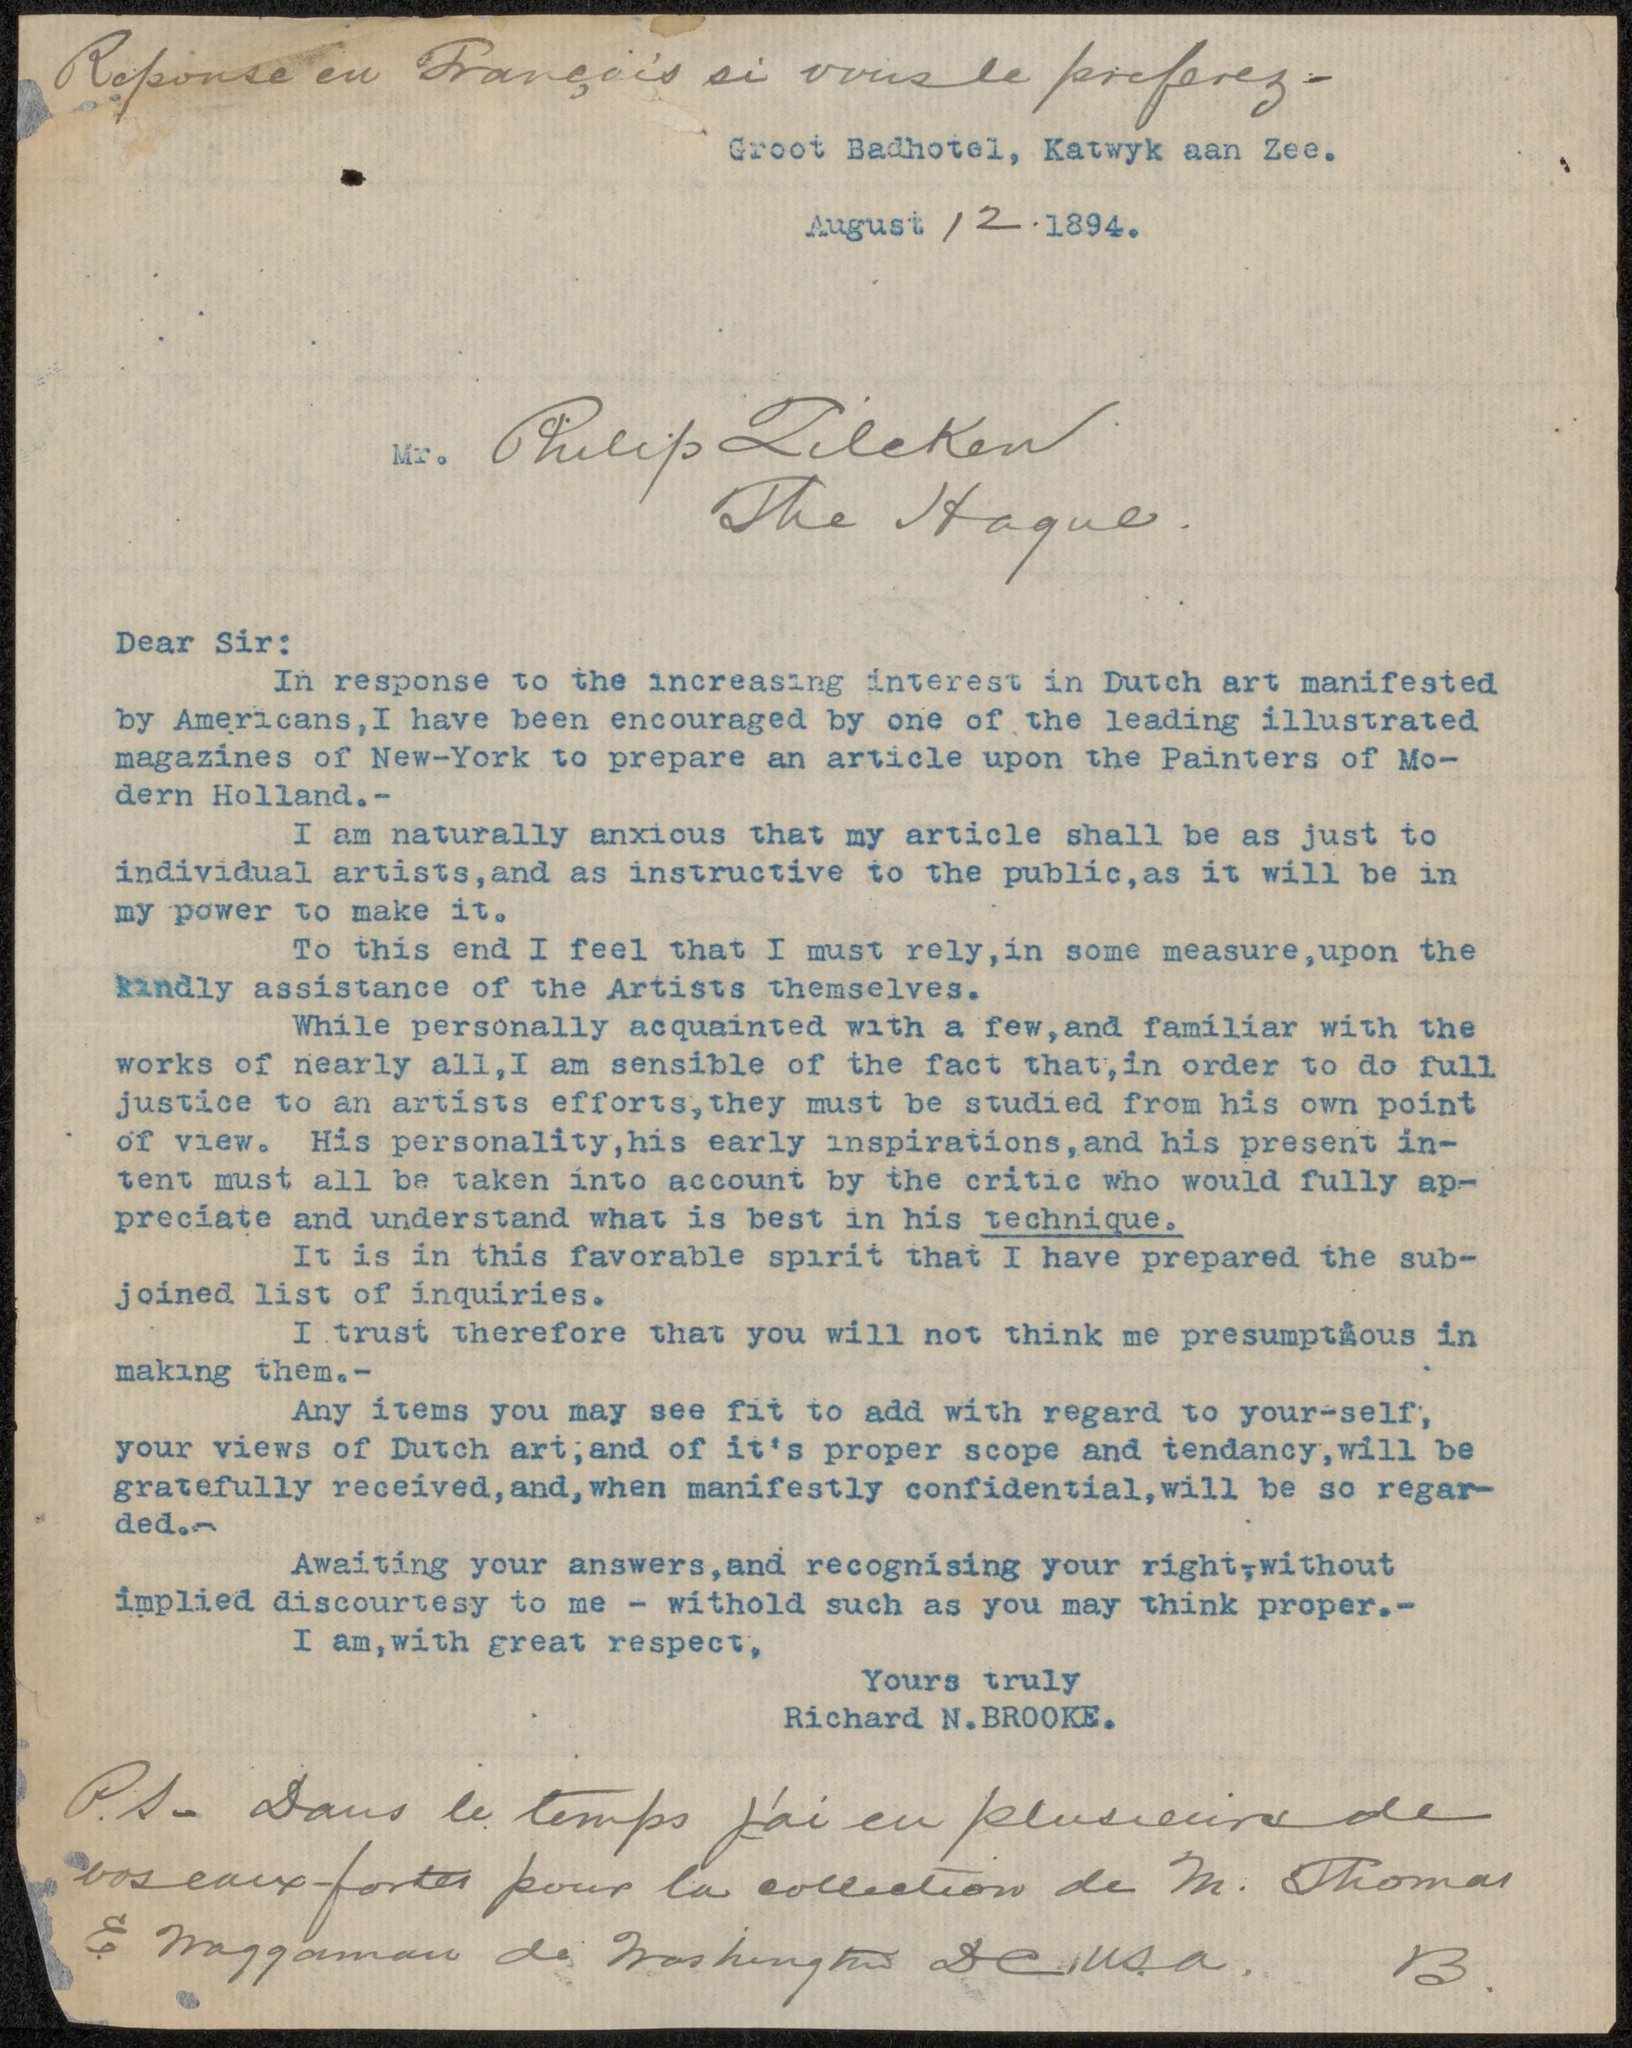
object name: letter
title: Brief aan Philip Zilcken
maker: richard norris brooke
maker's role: painter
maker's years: 1847-1920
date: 1894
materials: ink, paper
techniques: pen, typewriting, writing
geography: katwijk aan zee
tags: painter, draughtsman, philip zilcken, criticizing and discussing art, art criticism, the graphic arts, painting (including book-illumination, miniature-painting), art collecting, printed matter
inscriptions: watermark